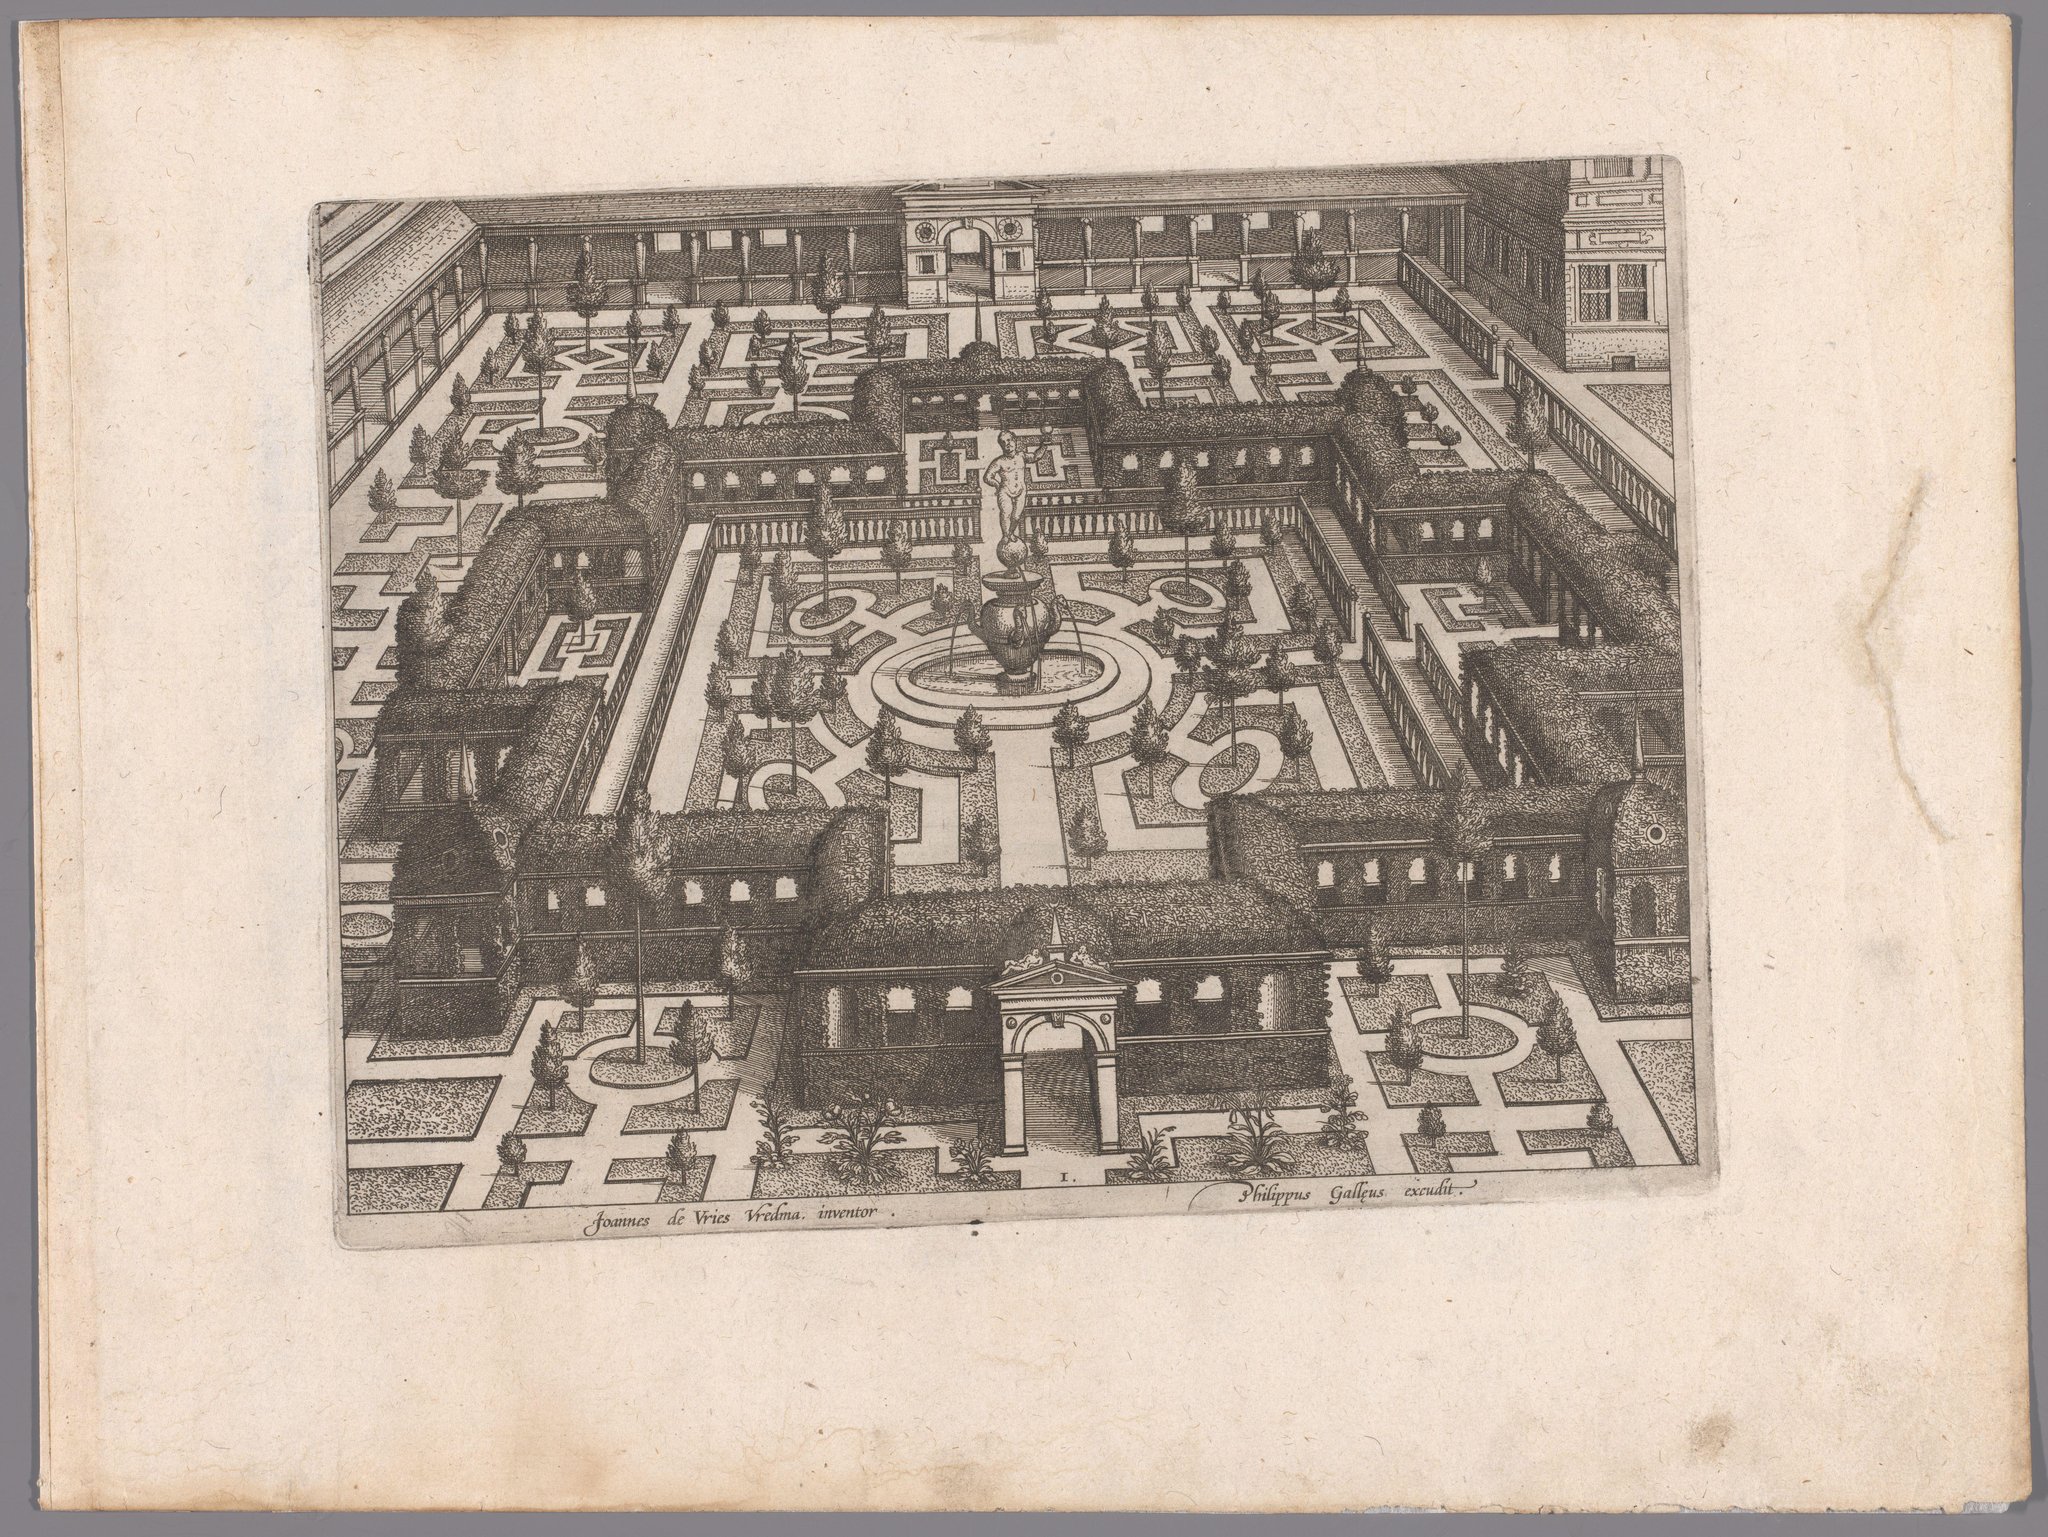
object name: print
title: Tuinen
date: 1587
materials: paper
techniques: etching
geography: antwerp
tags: garden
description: Deel van een ontmanteld album waarvan RP-P-2013-1-54-1 t/m -37, RP-P-2013-1-55-1 en -2 en RP-P-2013-1-63 en 65 t/m 67 ook deel waren.